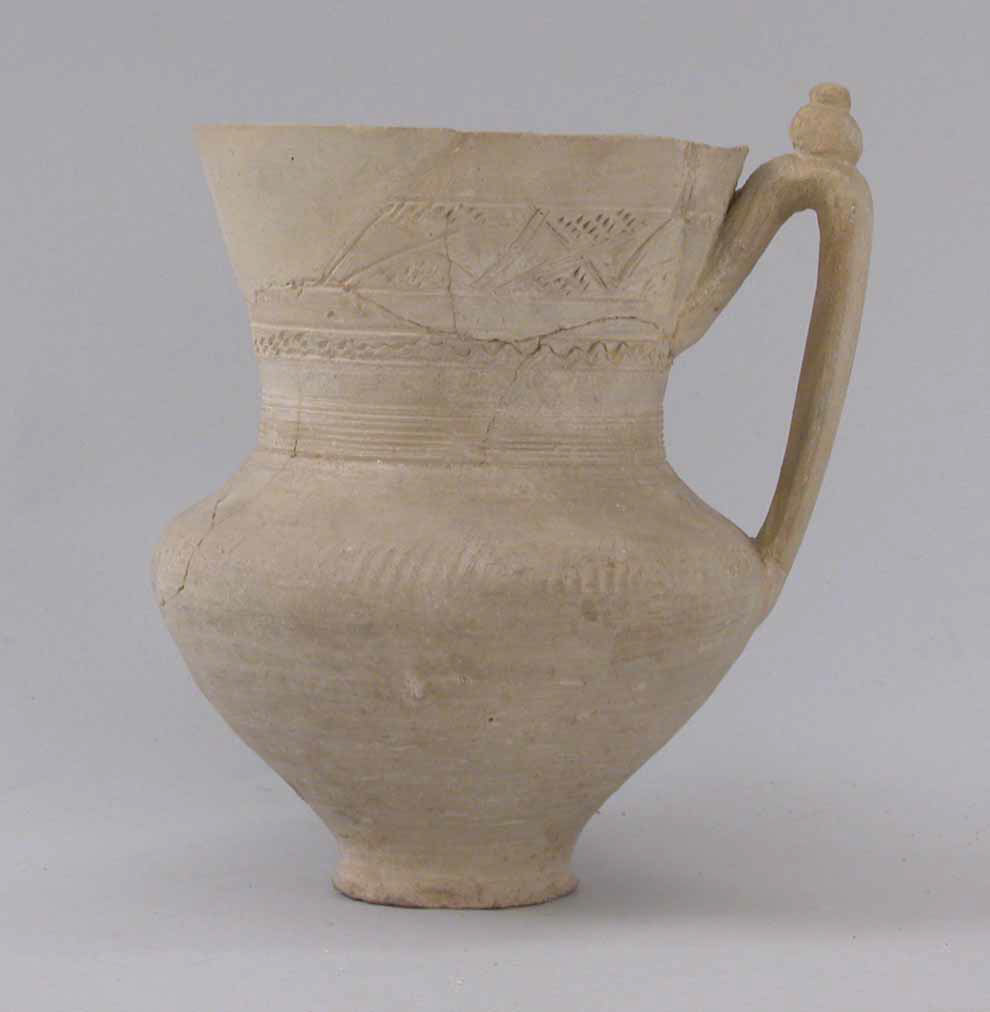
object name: jug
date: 801-900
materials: earthenware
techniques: incising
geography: iran